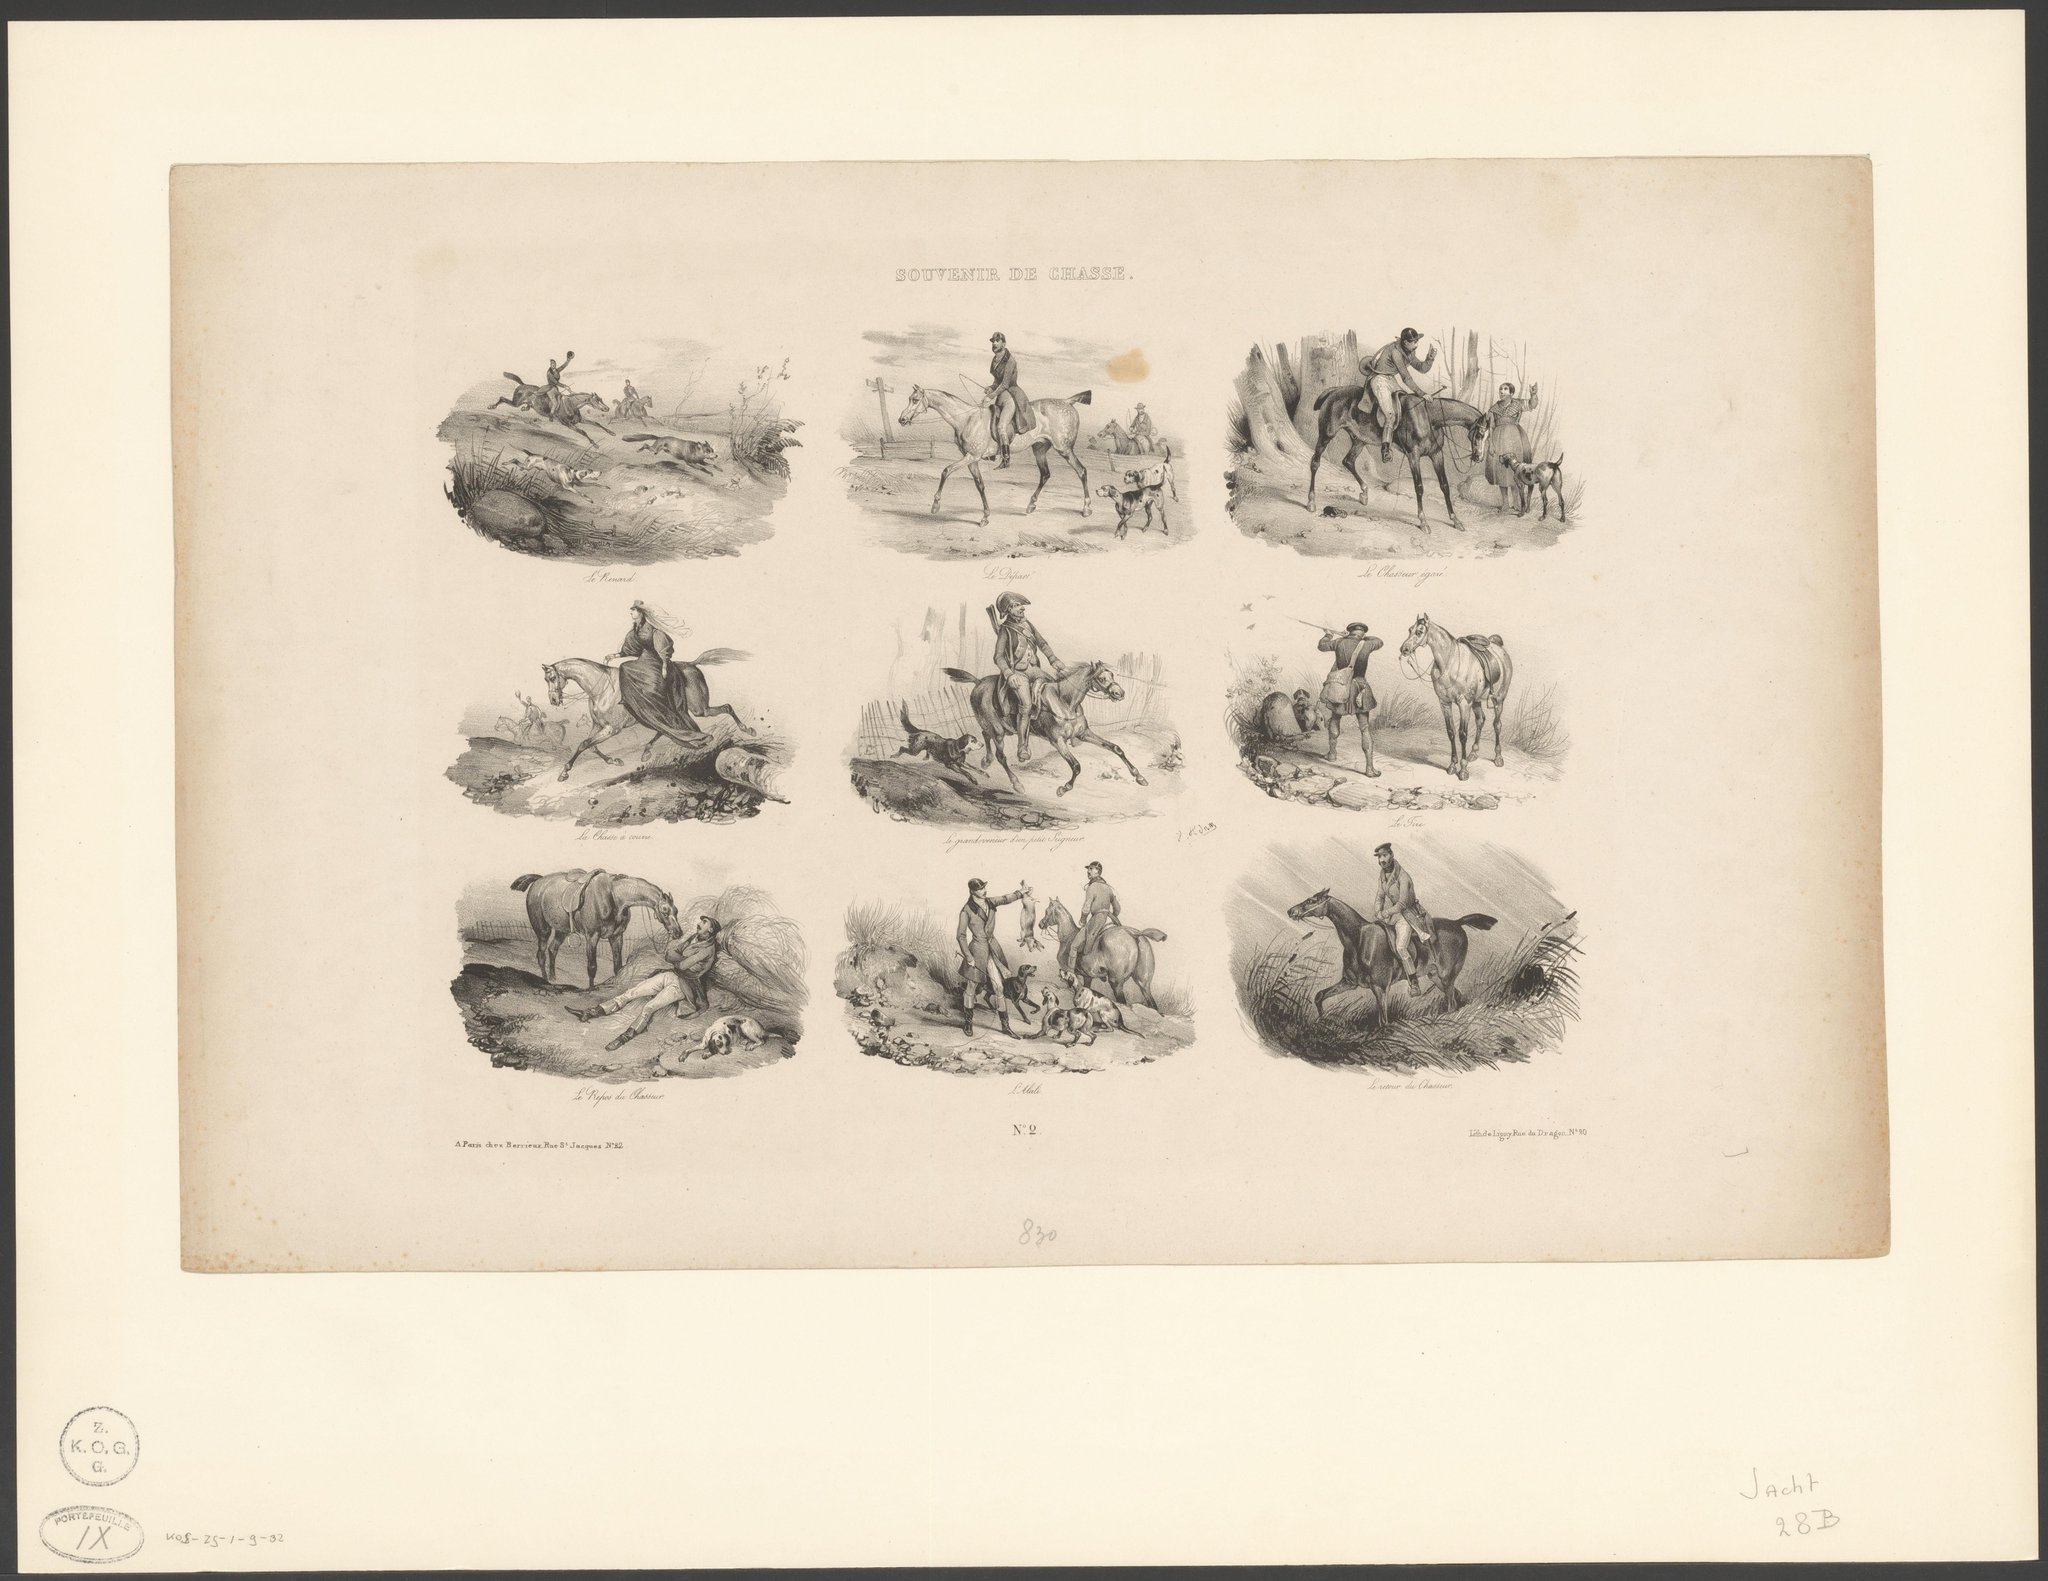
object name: print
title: Souvenir de chasse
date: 1827-1873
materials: paper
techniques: lithograph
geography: paris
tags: hunter, game, hunted animals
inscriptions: stamp, collector's mark: Lugt 1641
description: Negen voorstellingen over de jacht, van de vossenjacht tot de terugkeer na de jacht. Onderaan genummerd: No. 2. Onderwerpsrubrieken binnen de Atlas Zeden en Gewoonten: Handel, nijverheid en verkeer, jacht.